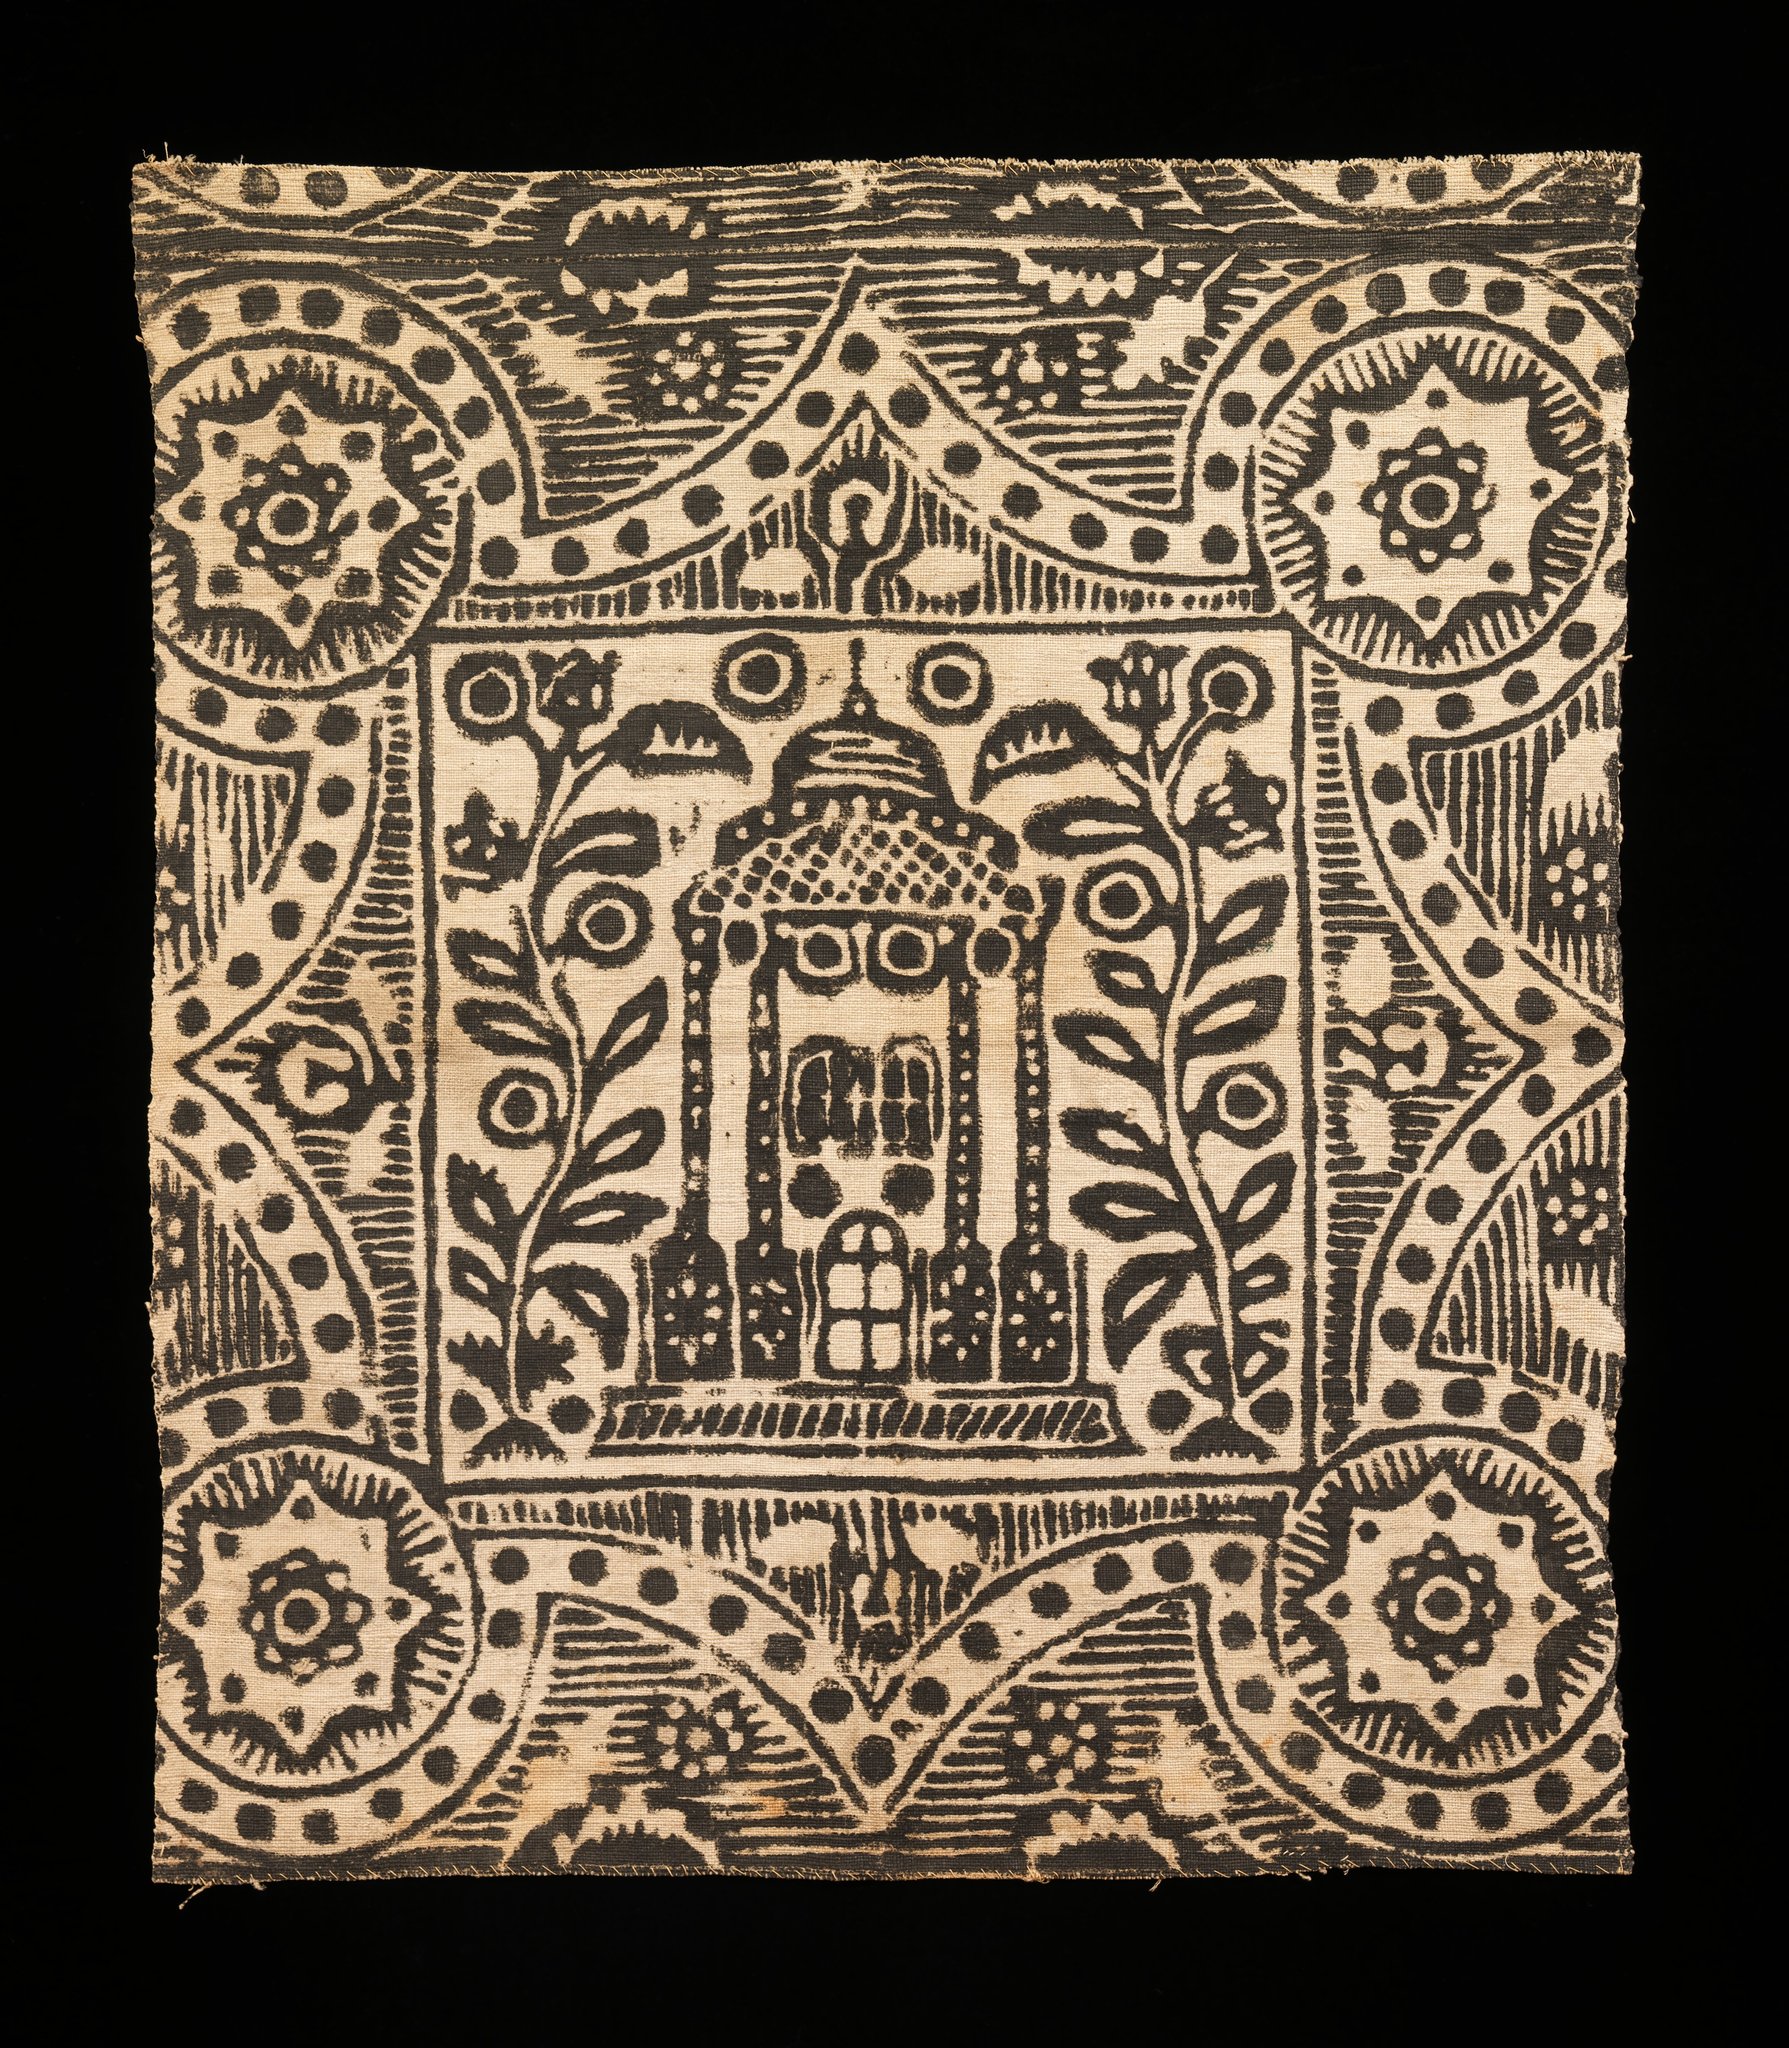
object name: textile fragment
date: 1700-1899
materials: linen